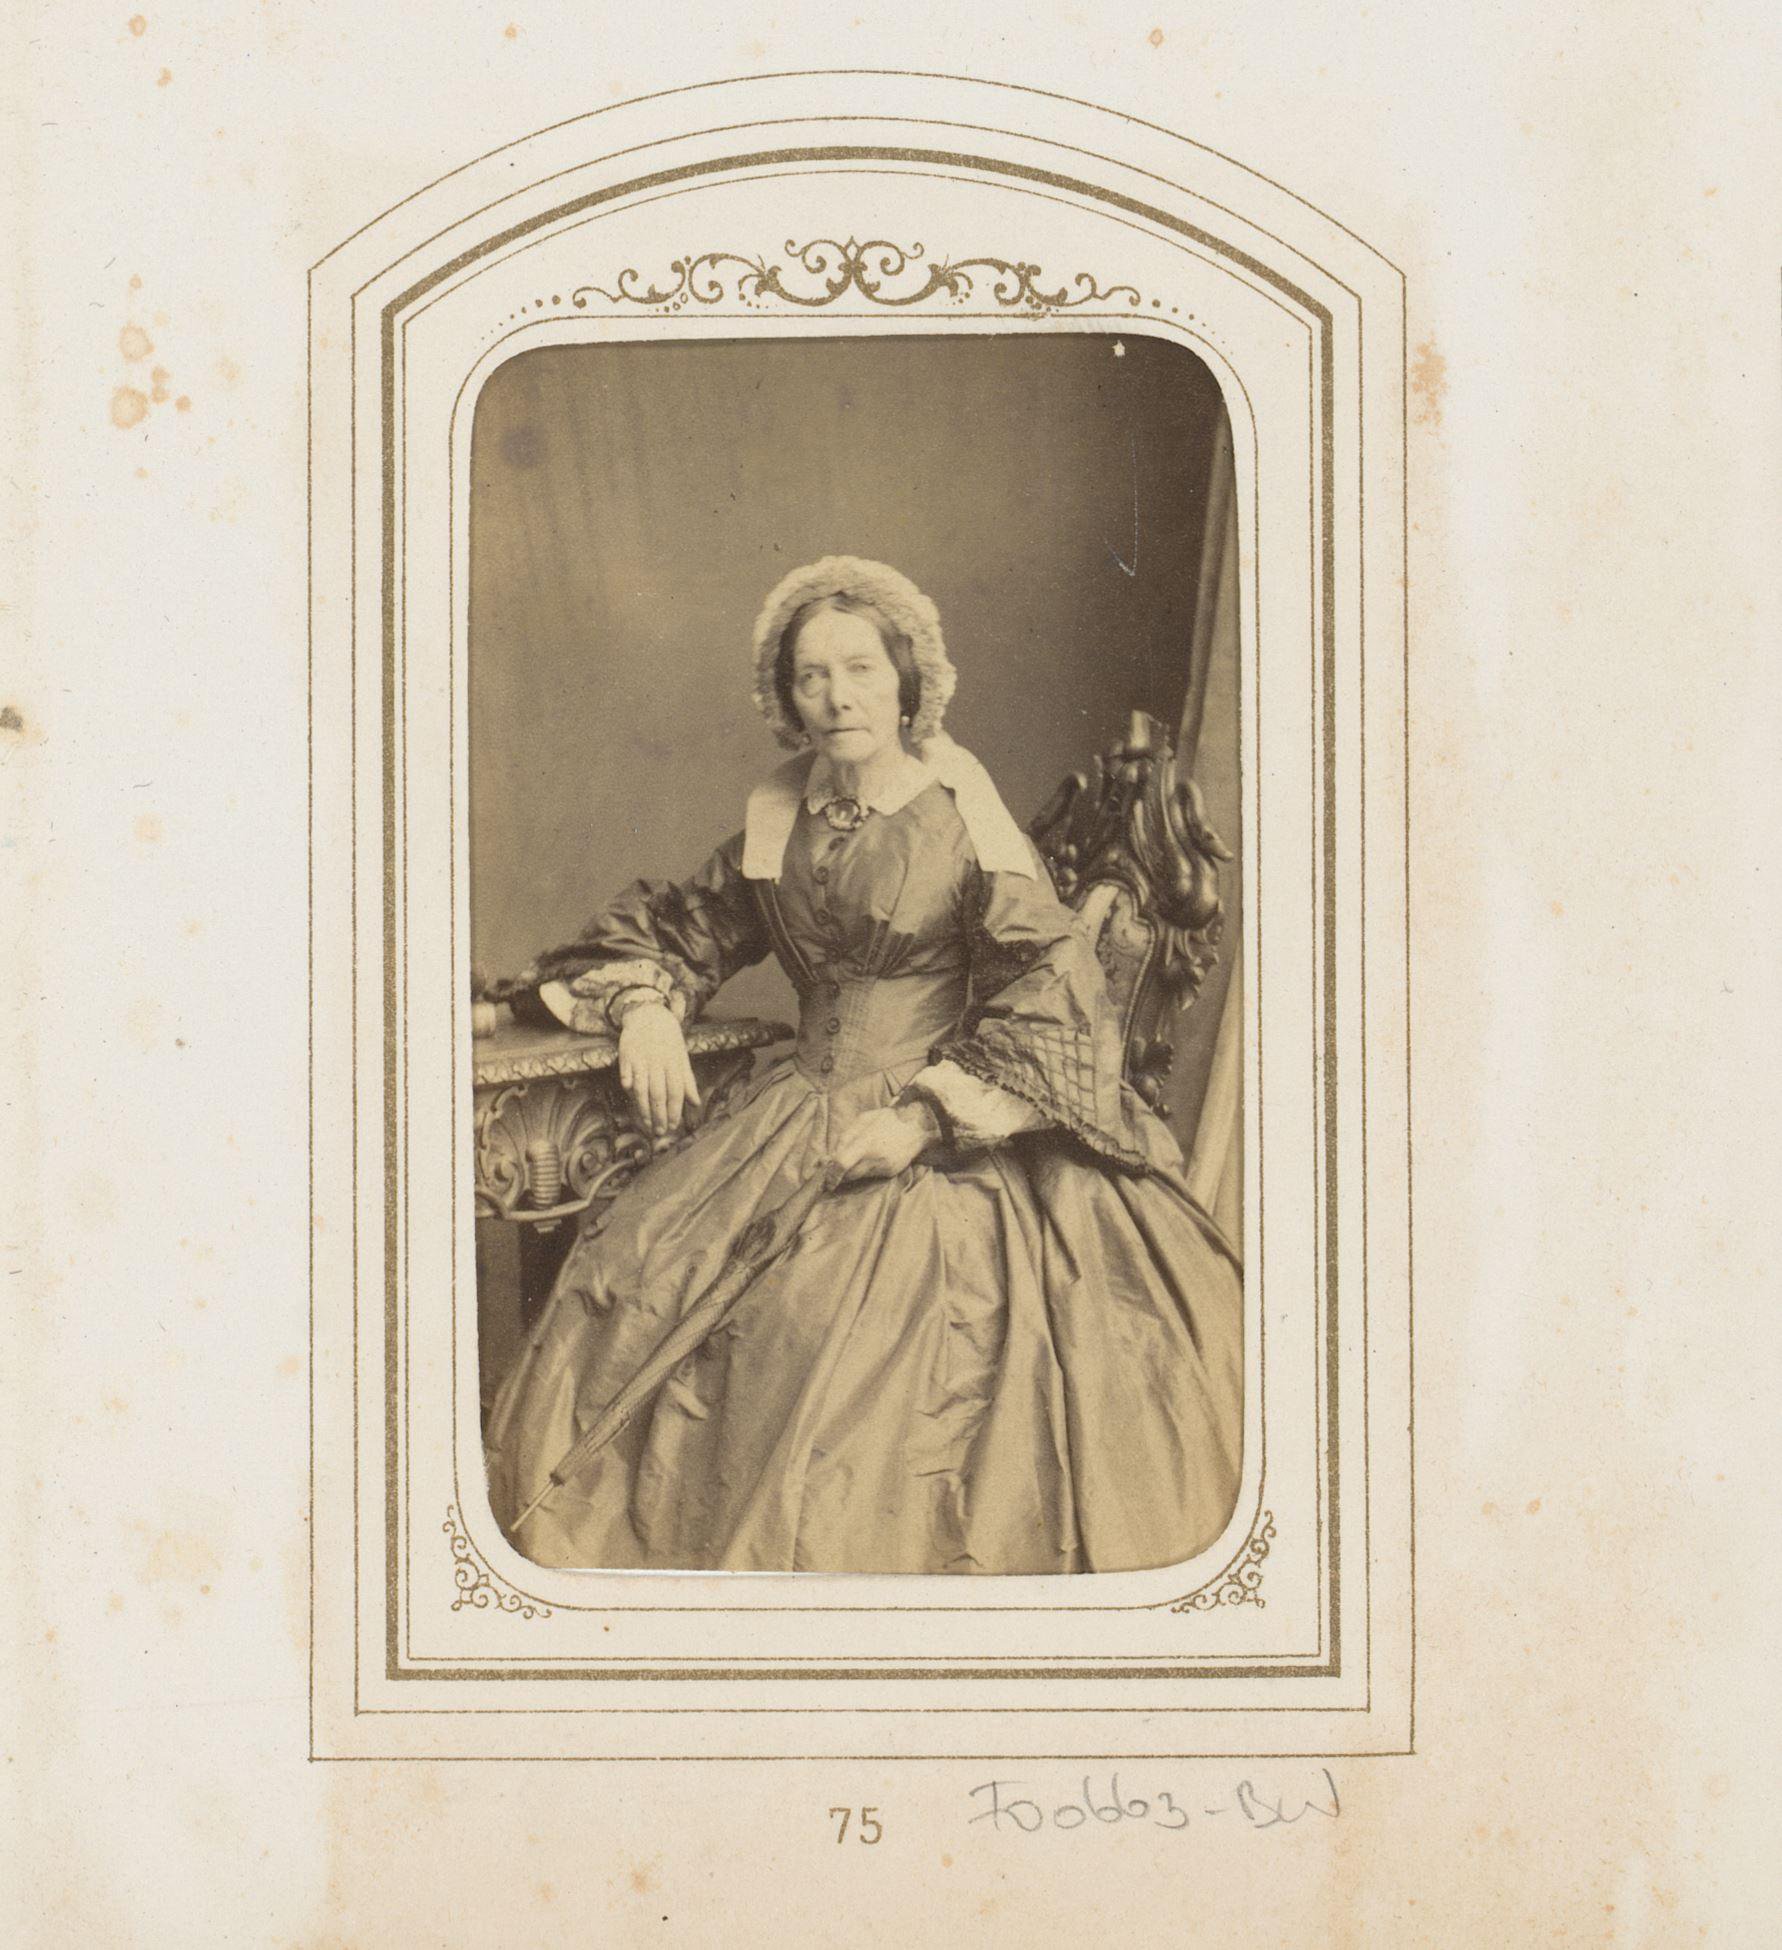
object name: photograph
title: Portret van een zittende oude vrouw met muts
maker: henri pronk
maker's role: fotograaf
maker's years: 1813-1893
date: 1858-1867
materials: cardboard, photographic support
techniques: albumen print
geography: the hague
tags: historical persons - bb - woman, head-gear: cap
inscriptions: number: ‘75’